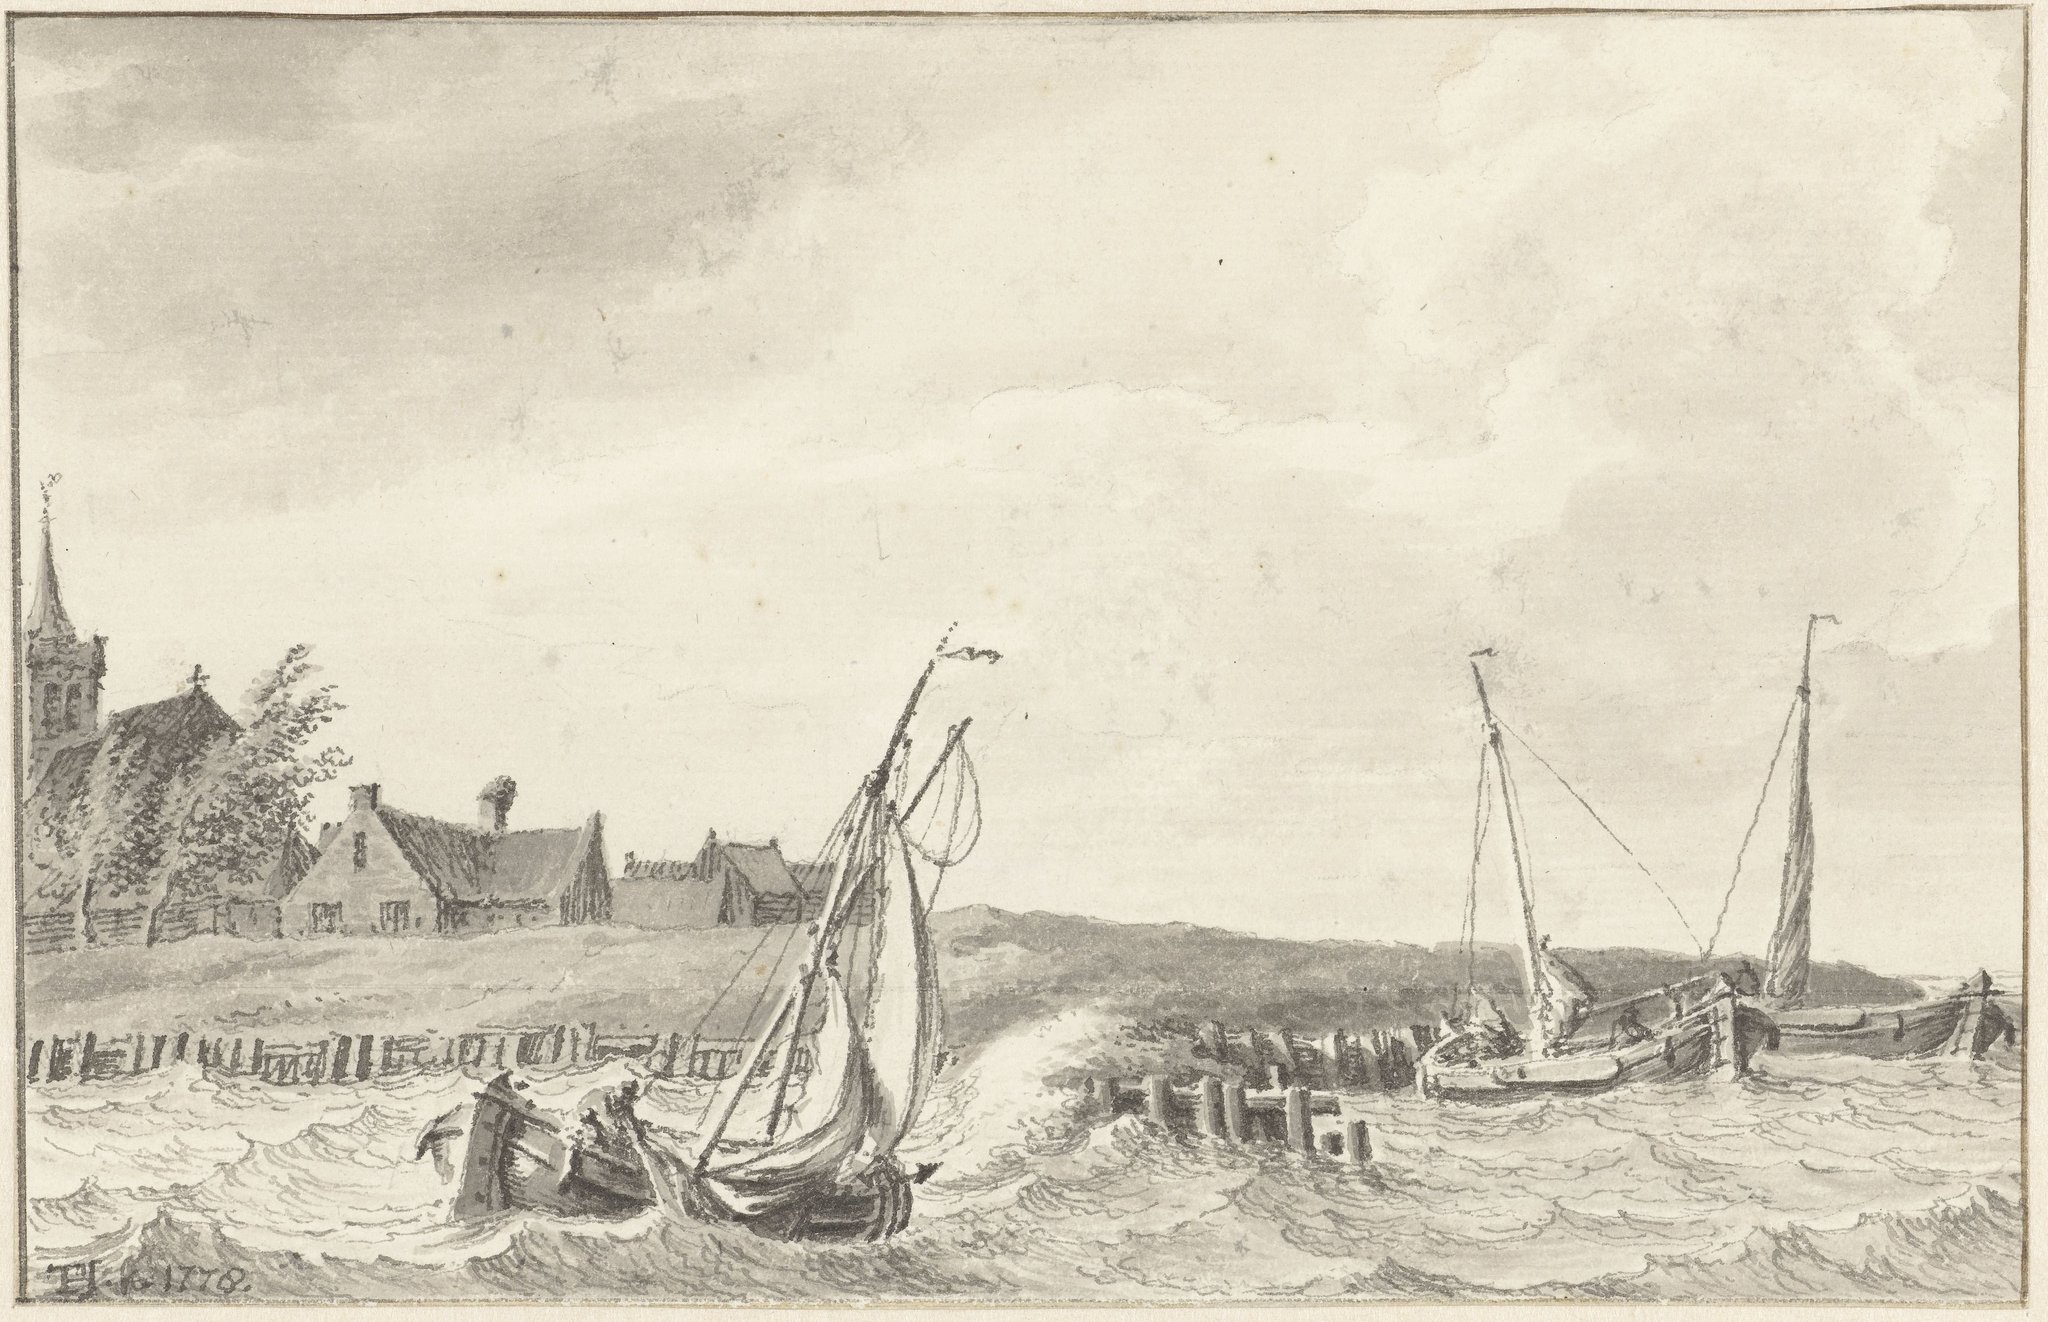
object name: drawing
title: Scheepjes bij een dijk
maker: tako hajo jelgersma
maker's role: draughtsman, painter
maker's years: 1702-1795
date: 1778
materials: ink, paper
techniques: brush, pen